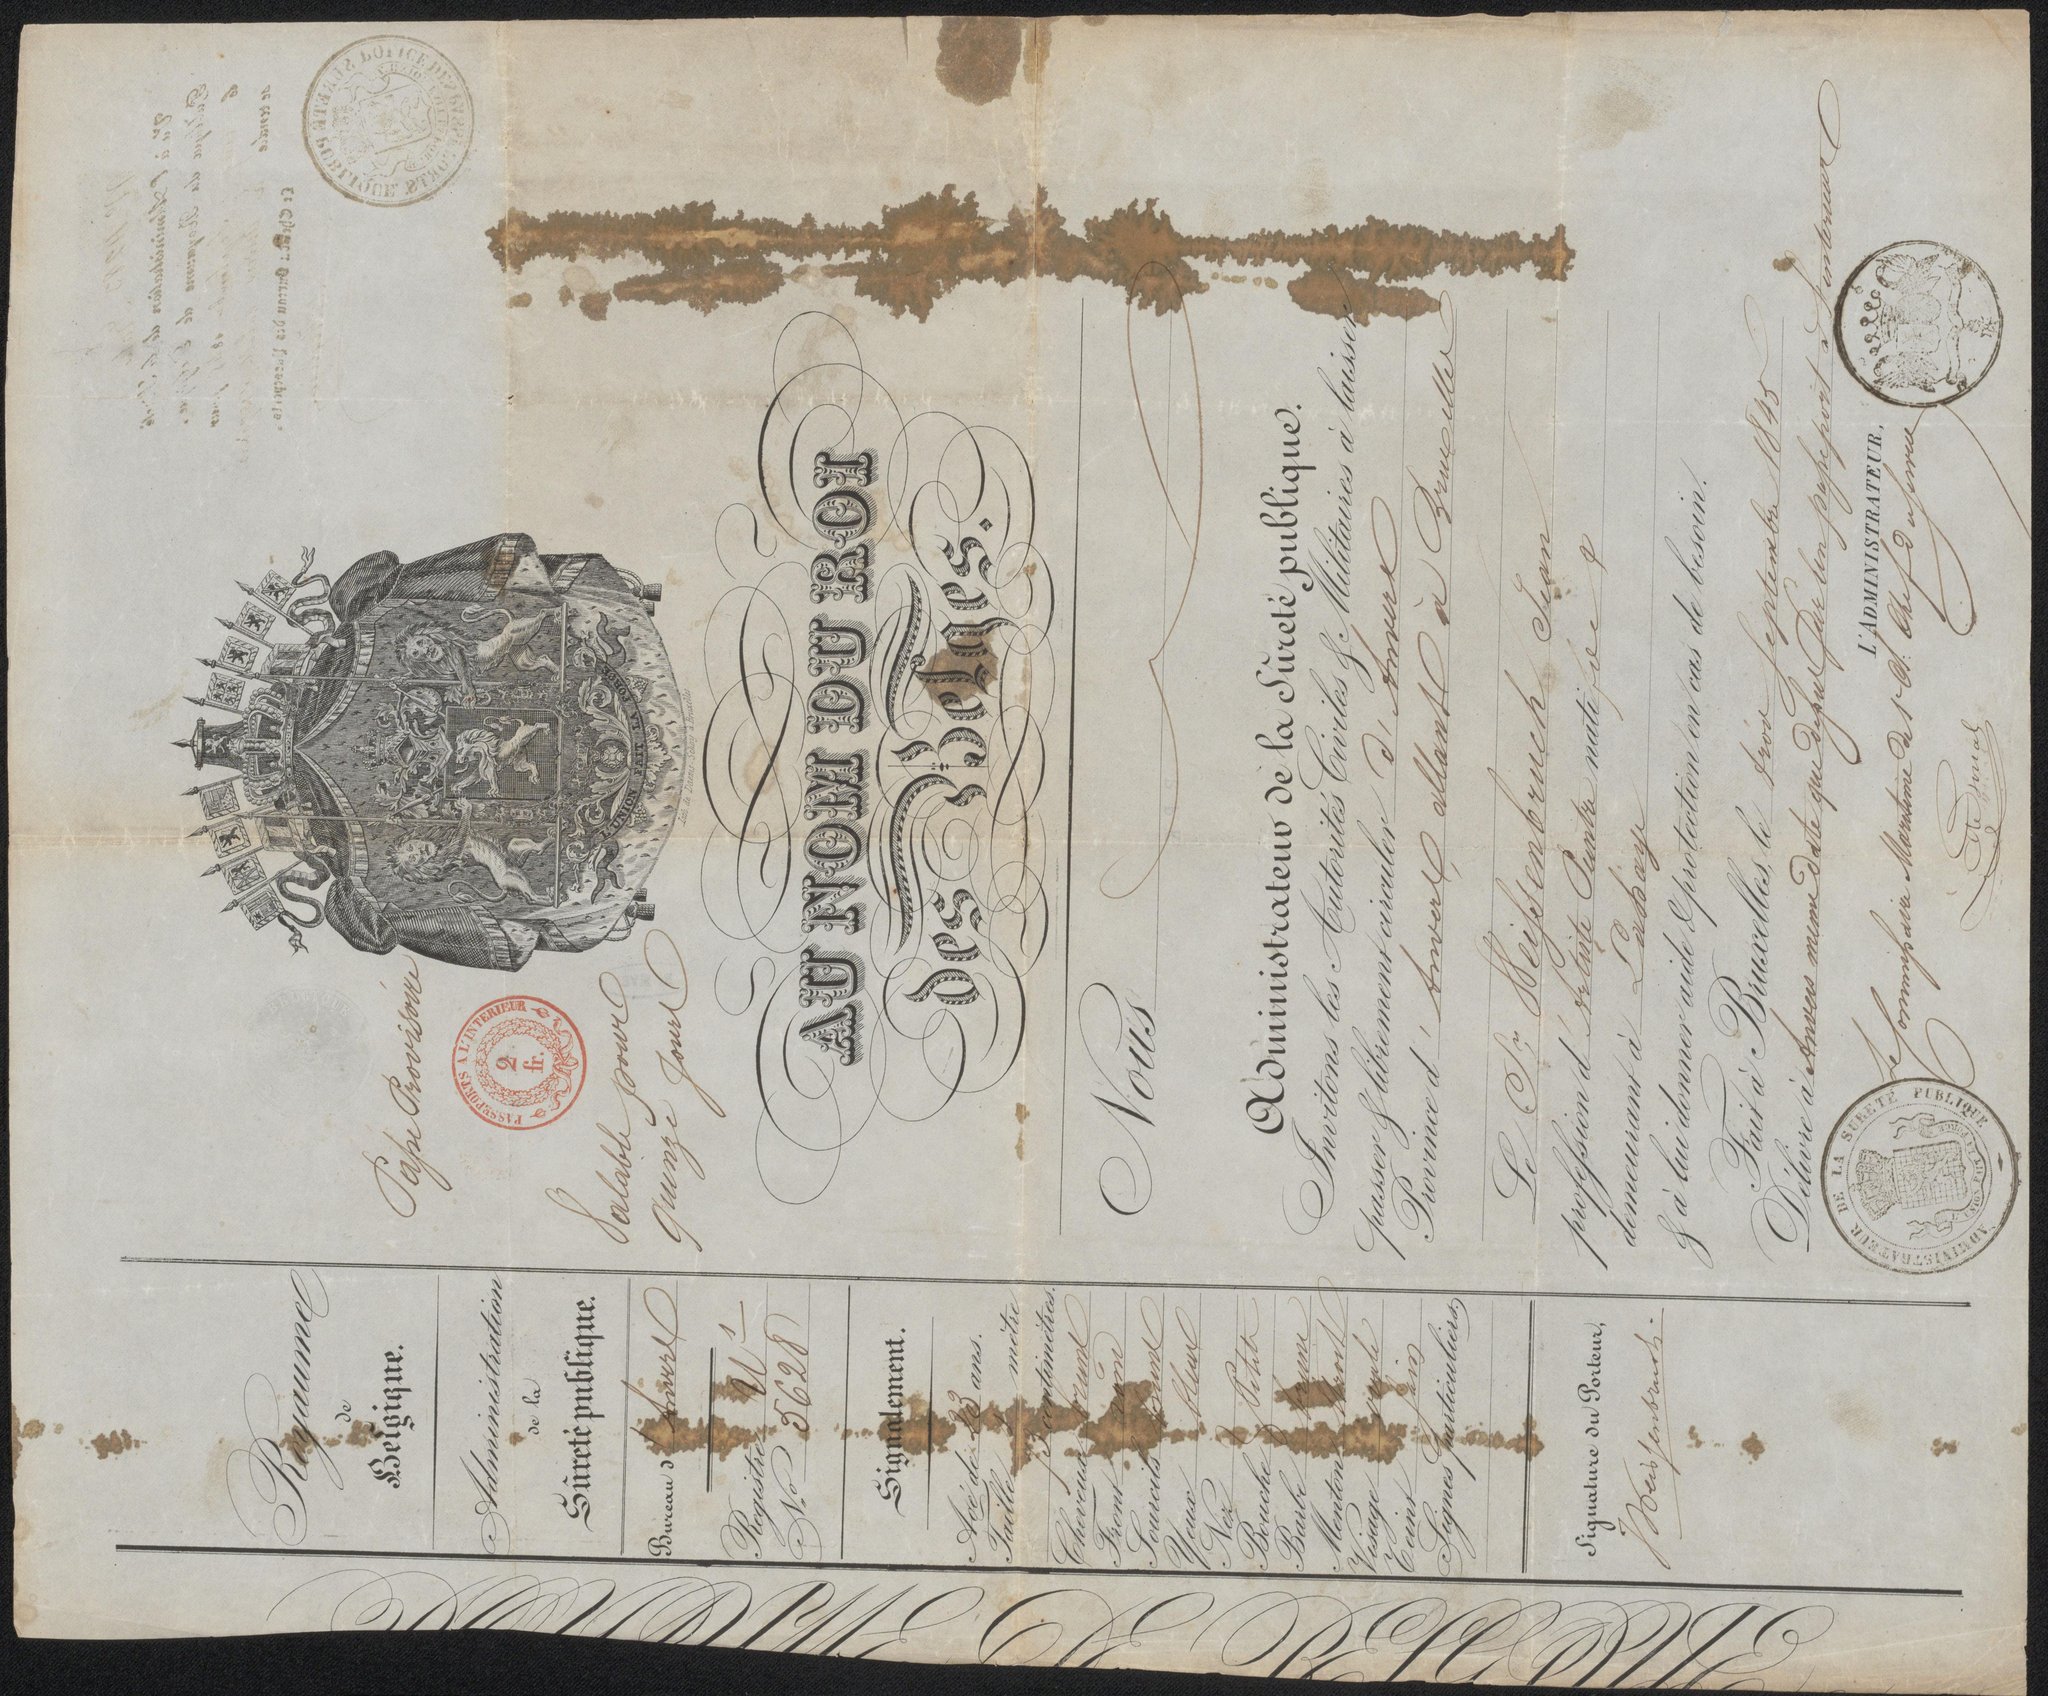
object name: travel document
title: Reisdocument van Jan Weissenbruch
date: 1809-1845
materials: ink, paper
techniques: pen, printing, writing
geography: antwerp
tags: the hague, painter, print maker, jan weissenbruch, belgium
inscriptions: collector's mark: Lugt 2233